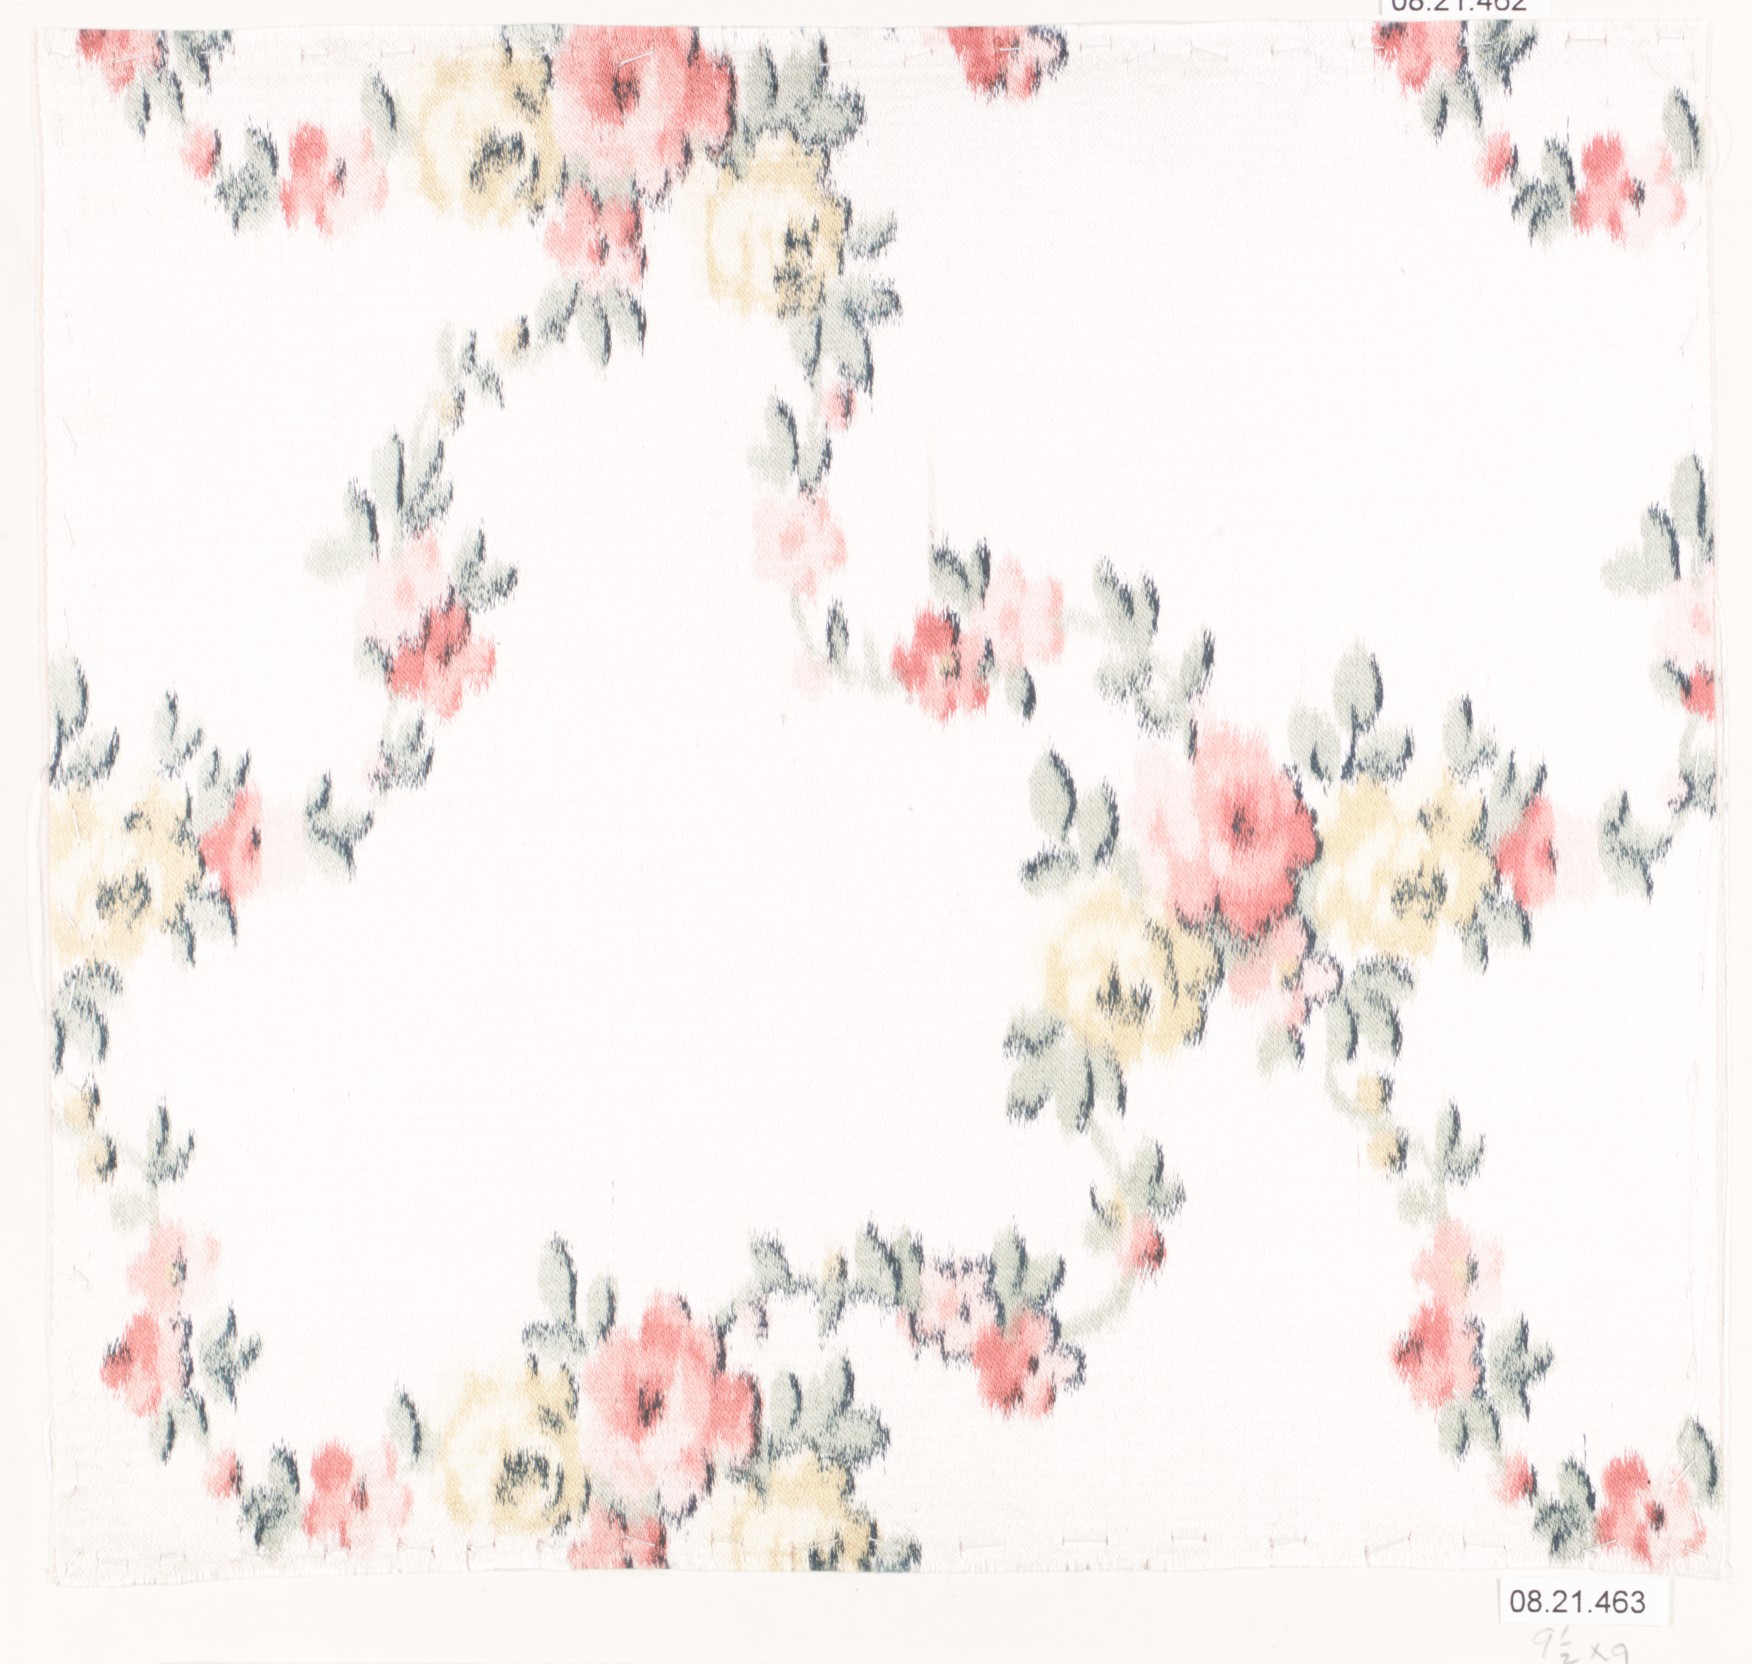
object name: textile sample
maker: Anonymous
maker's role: designer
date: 1900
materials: silk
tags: flowers